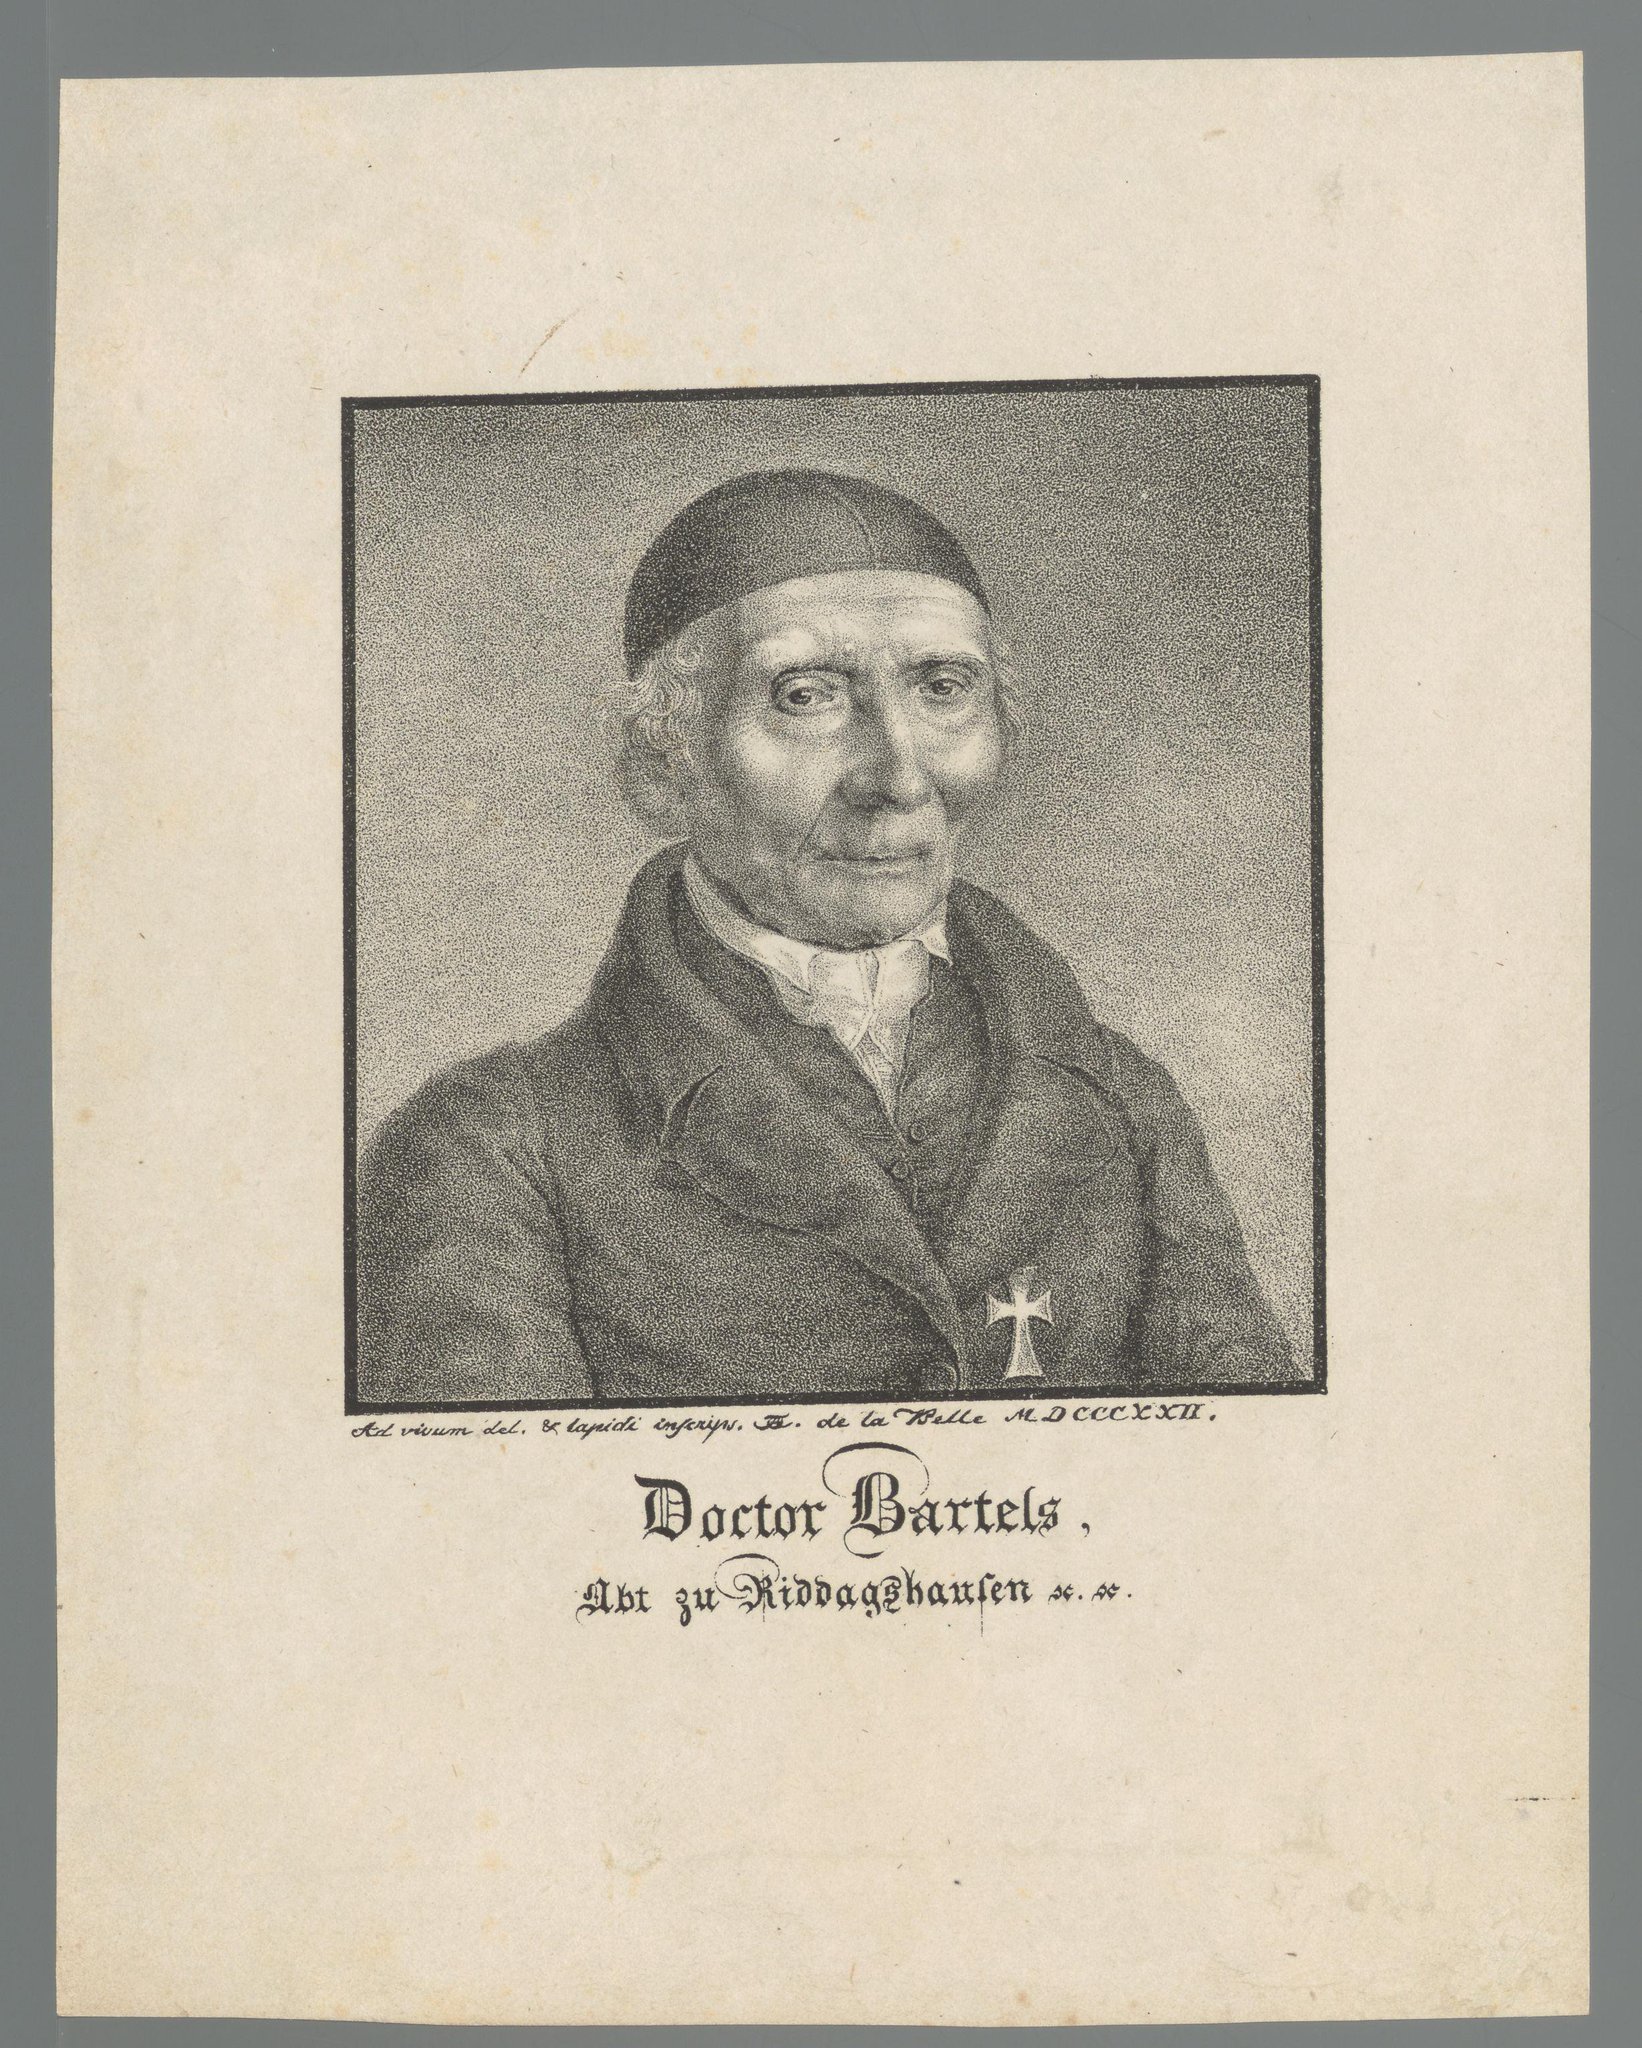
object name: print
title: Portret van August Christian Bartels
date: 1822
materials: paper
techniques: lithograph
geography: berlin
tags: head-gear, historical persons, old man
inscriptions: collector's mark: Lugt 2228